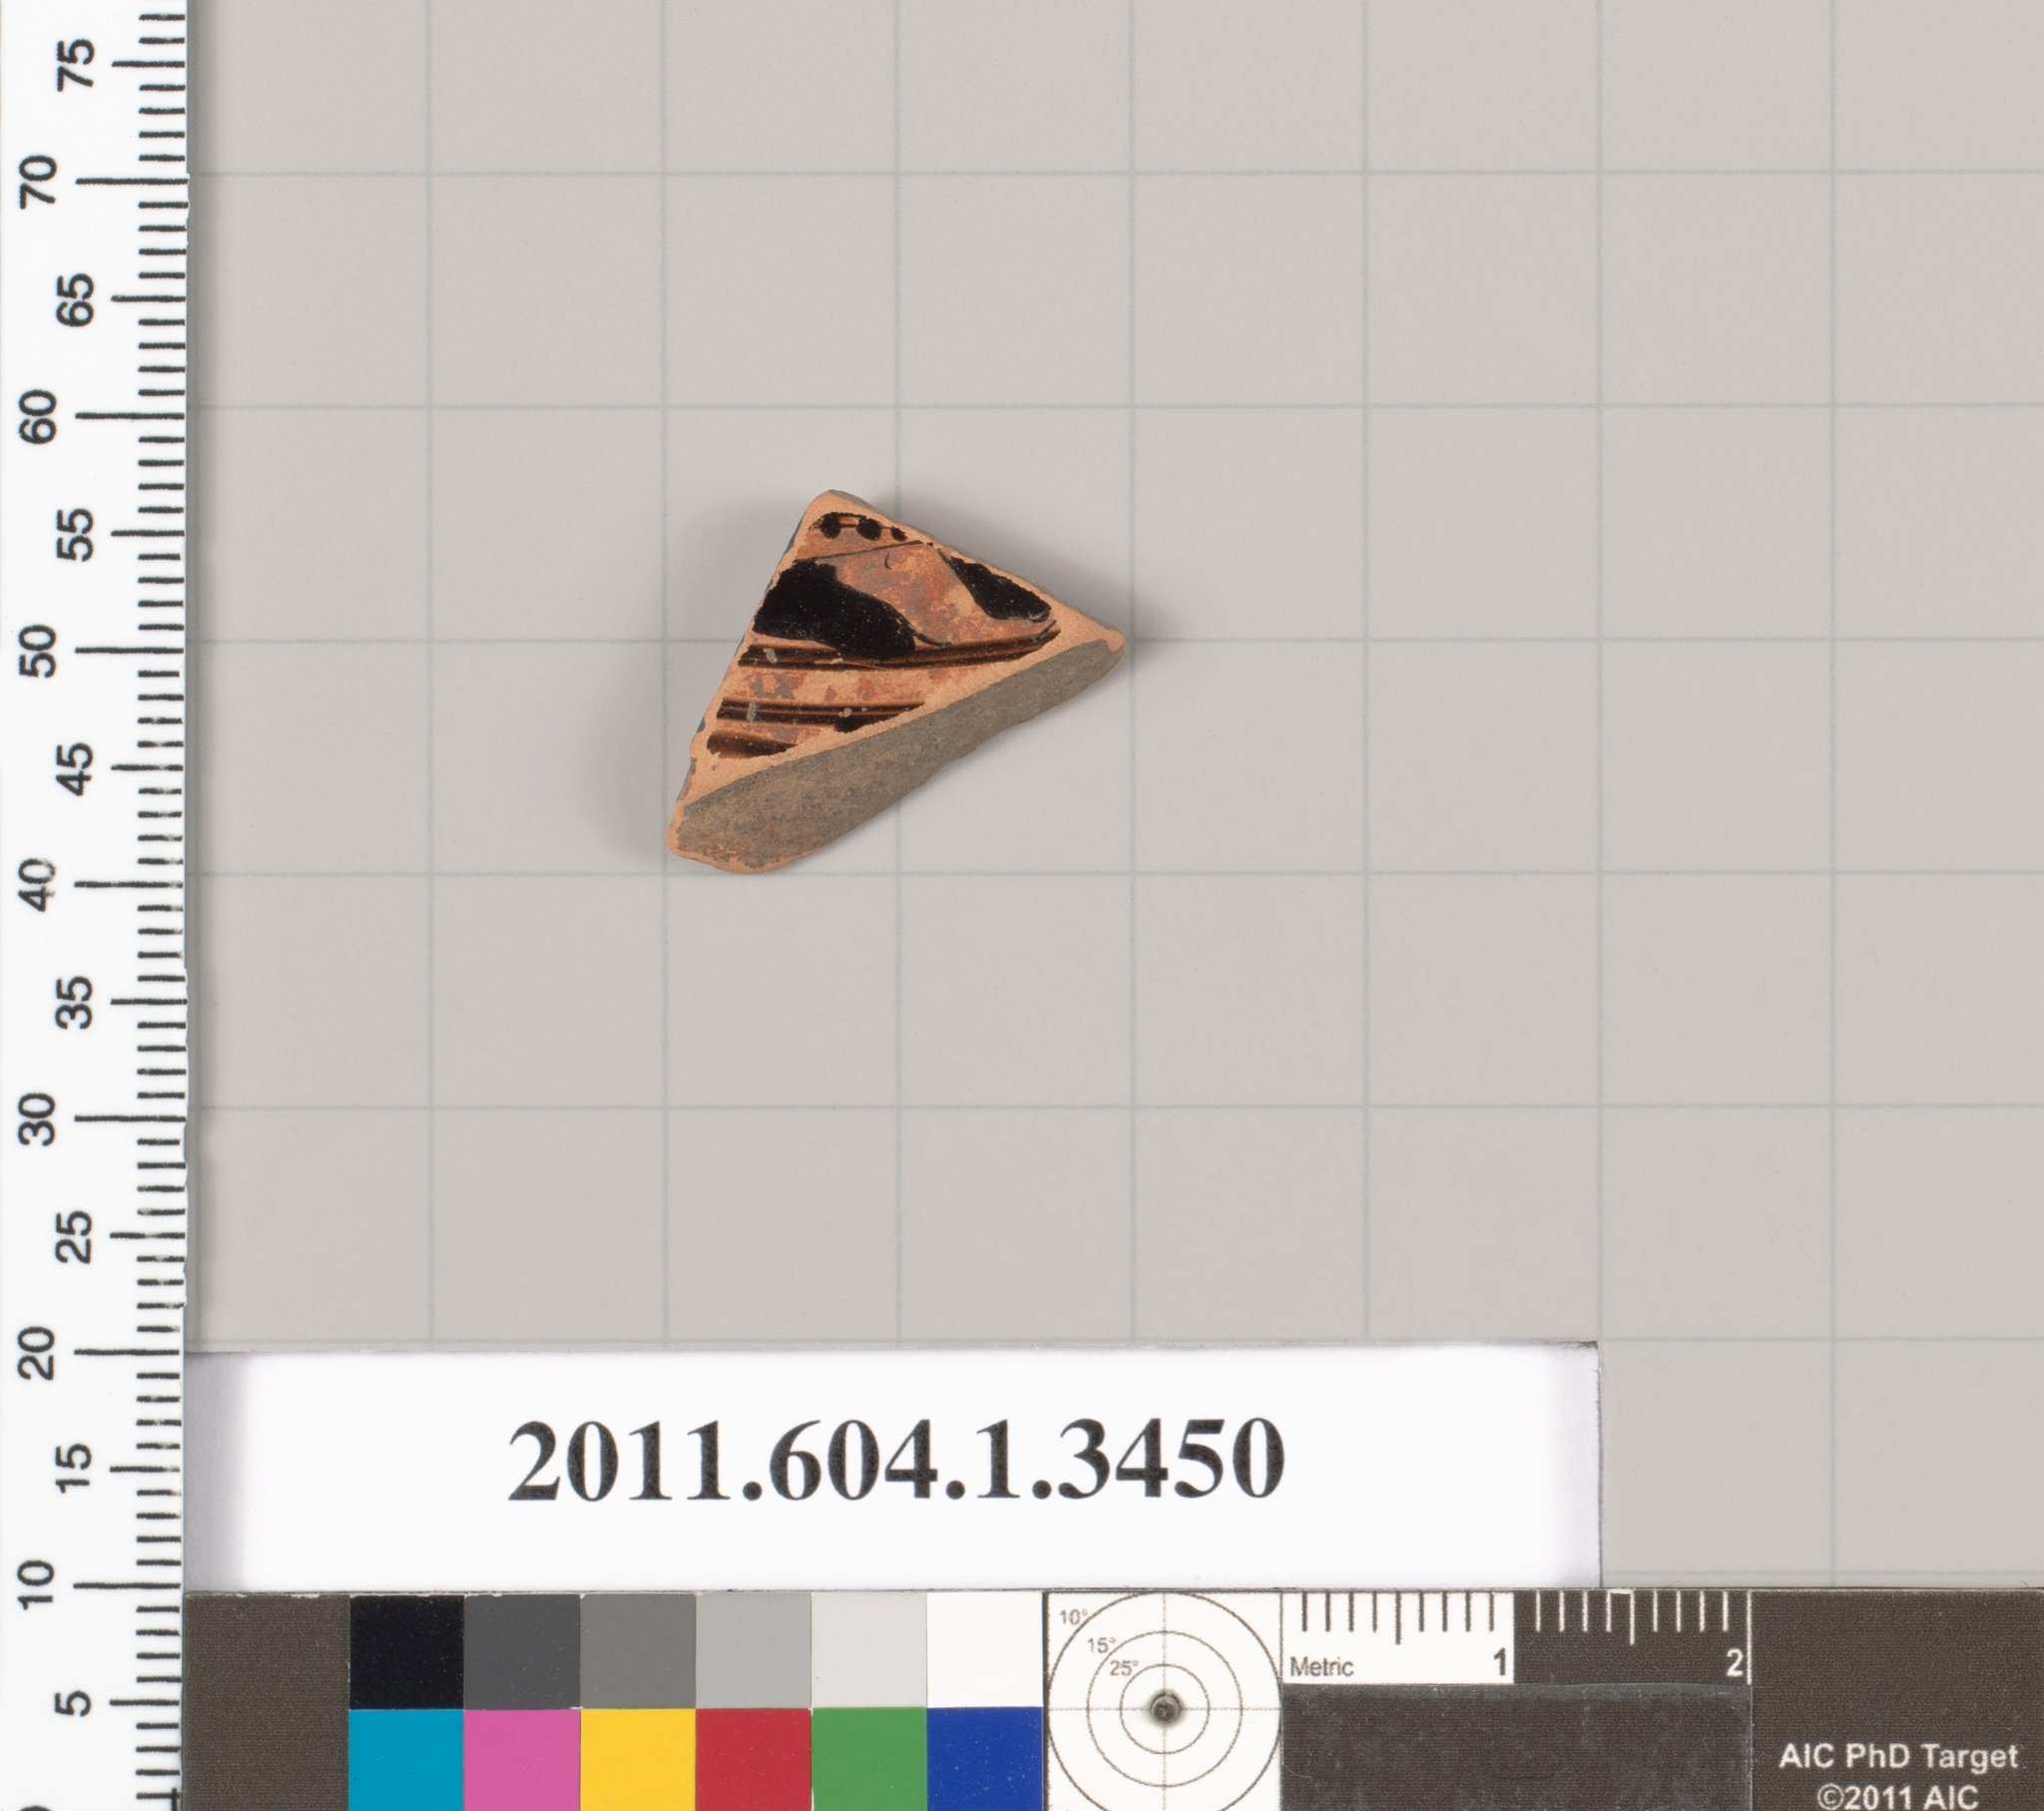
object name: kylix fragment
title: Terracotta fragment of a kylix (drinking cup)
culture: greek, attic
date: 475-451 BCE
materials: terracotta